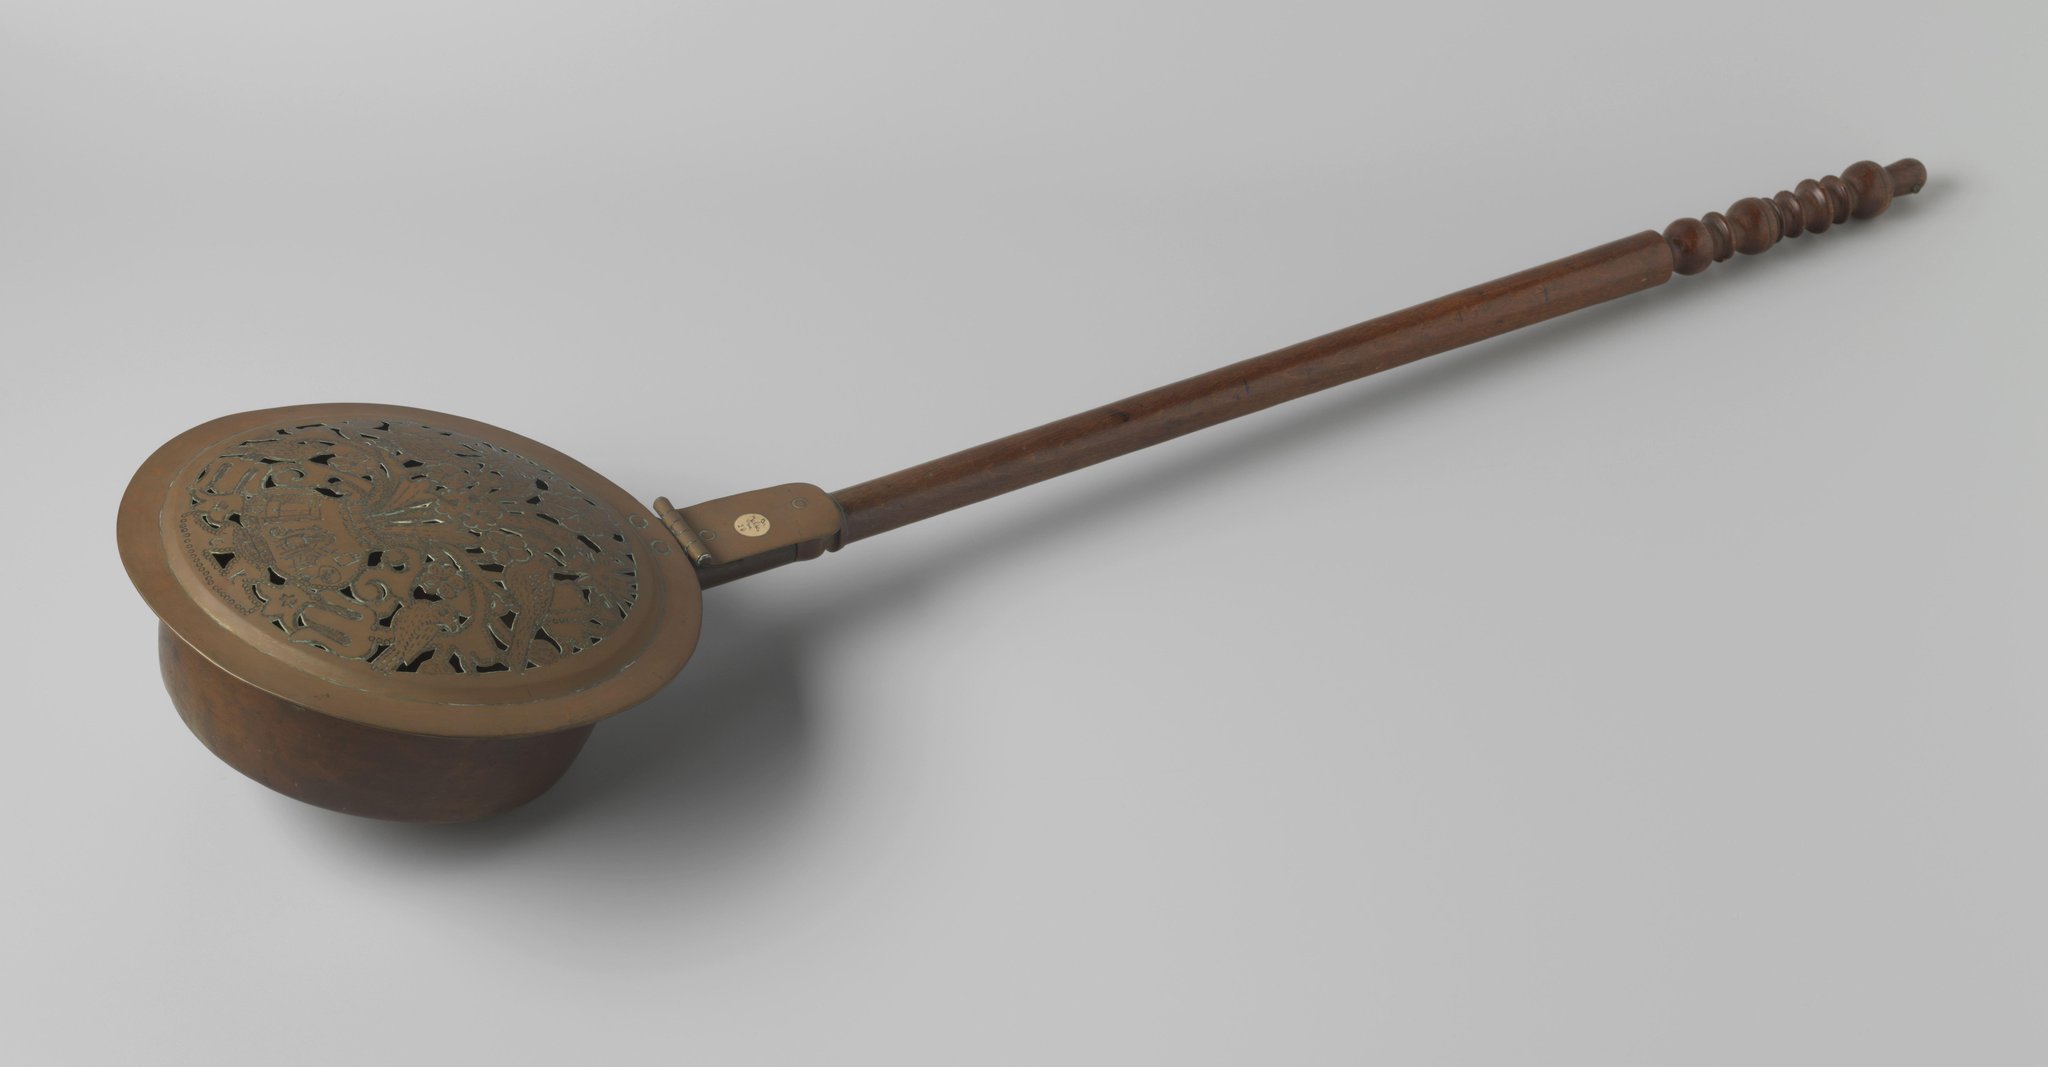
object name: bed warmer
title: Beddenpan met bloemenvaas en vogels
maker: Anonymous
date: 1600-1700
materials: brass, iron, wood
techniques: casting, cutting, granulation, punching, striking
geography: low countries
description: Het voorwerp bestaat uit zes delen: de smeedijzeren ring, de bak, het deksel, het scharnier en de houten steel. Bak, deksel en scharnier zijn gemaakt van koperplaat. Het bolle deksel, waarvan het centerpunt zichtbaar is geblevenen dat aan de onderkant is geslagen om een roodkoperen versteviging met verticale rand, heeft een met gegranuleerde lijnen aangegeven en uitgesneden gestileerd decor van een vaas met een bloem met daaromheen vogels. Op de vaas is een huiselijk tafereel te zien, met onder andere een tafel en stoel, schilderijtje en een kast. De houten steel is onderaan geprofileerd, bovenaan geribd. De steel is waarschijnlijk gemaakt in de 18de eeuw.